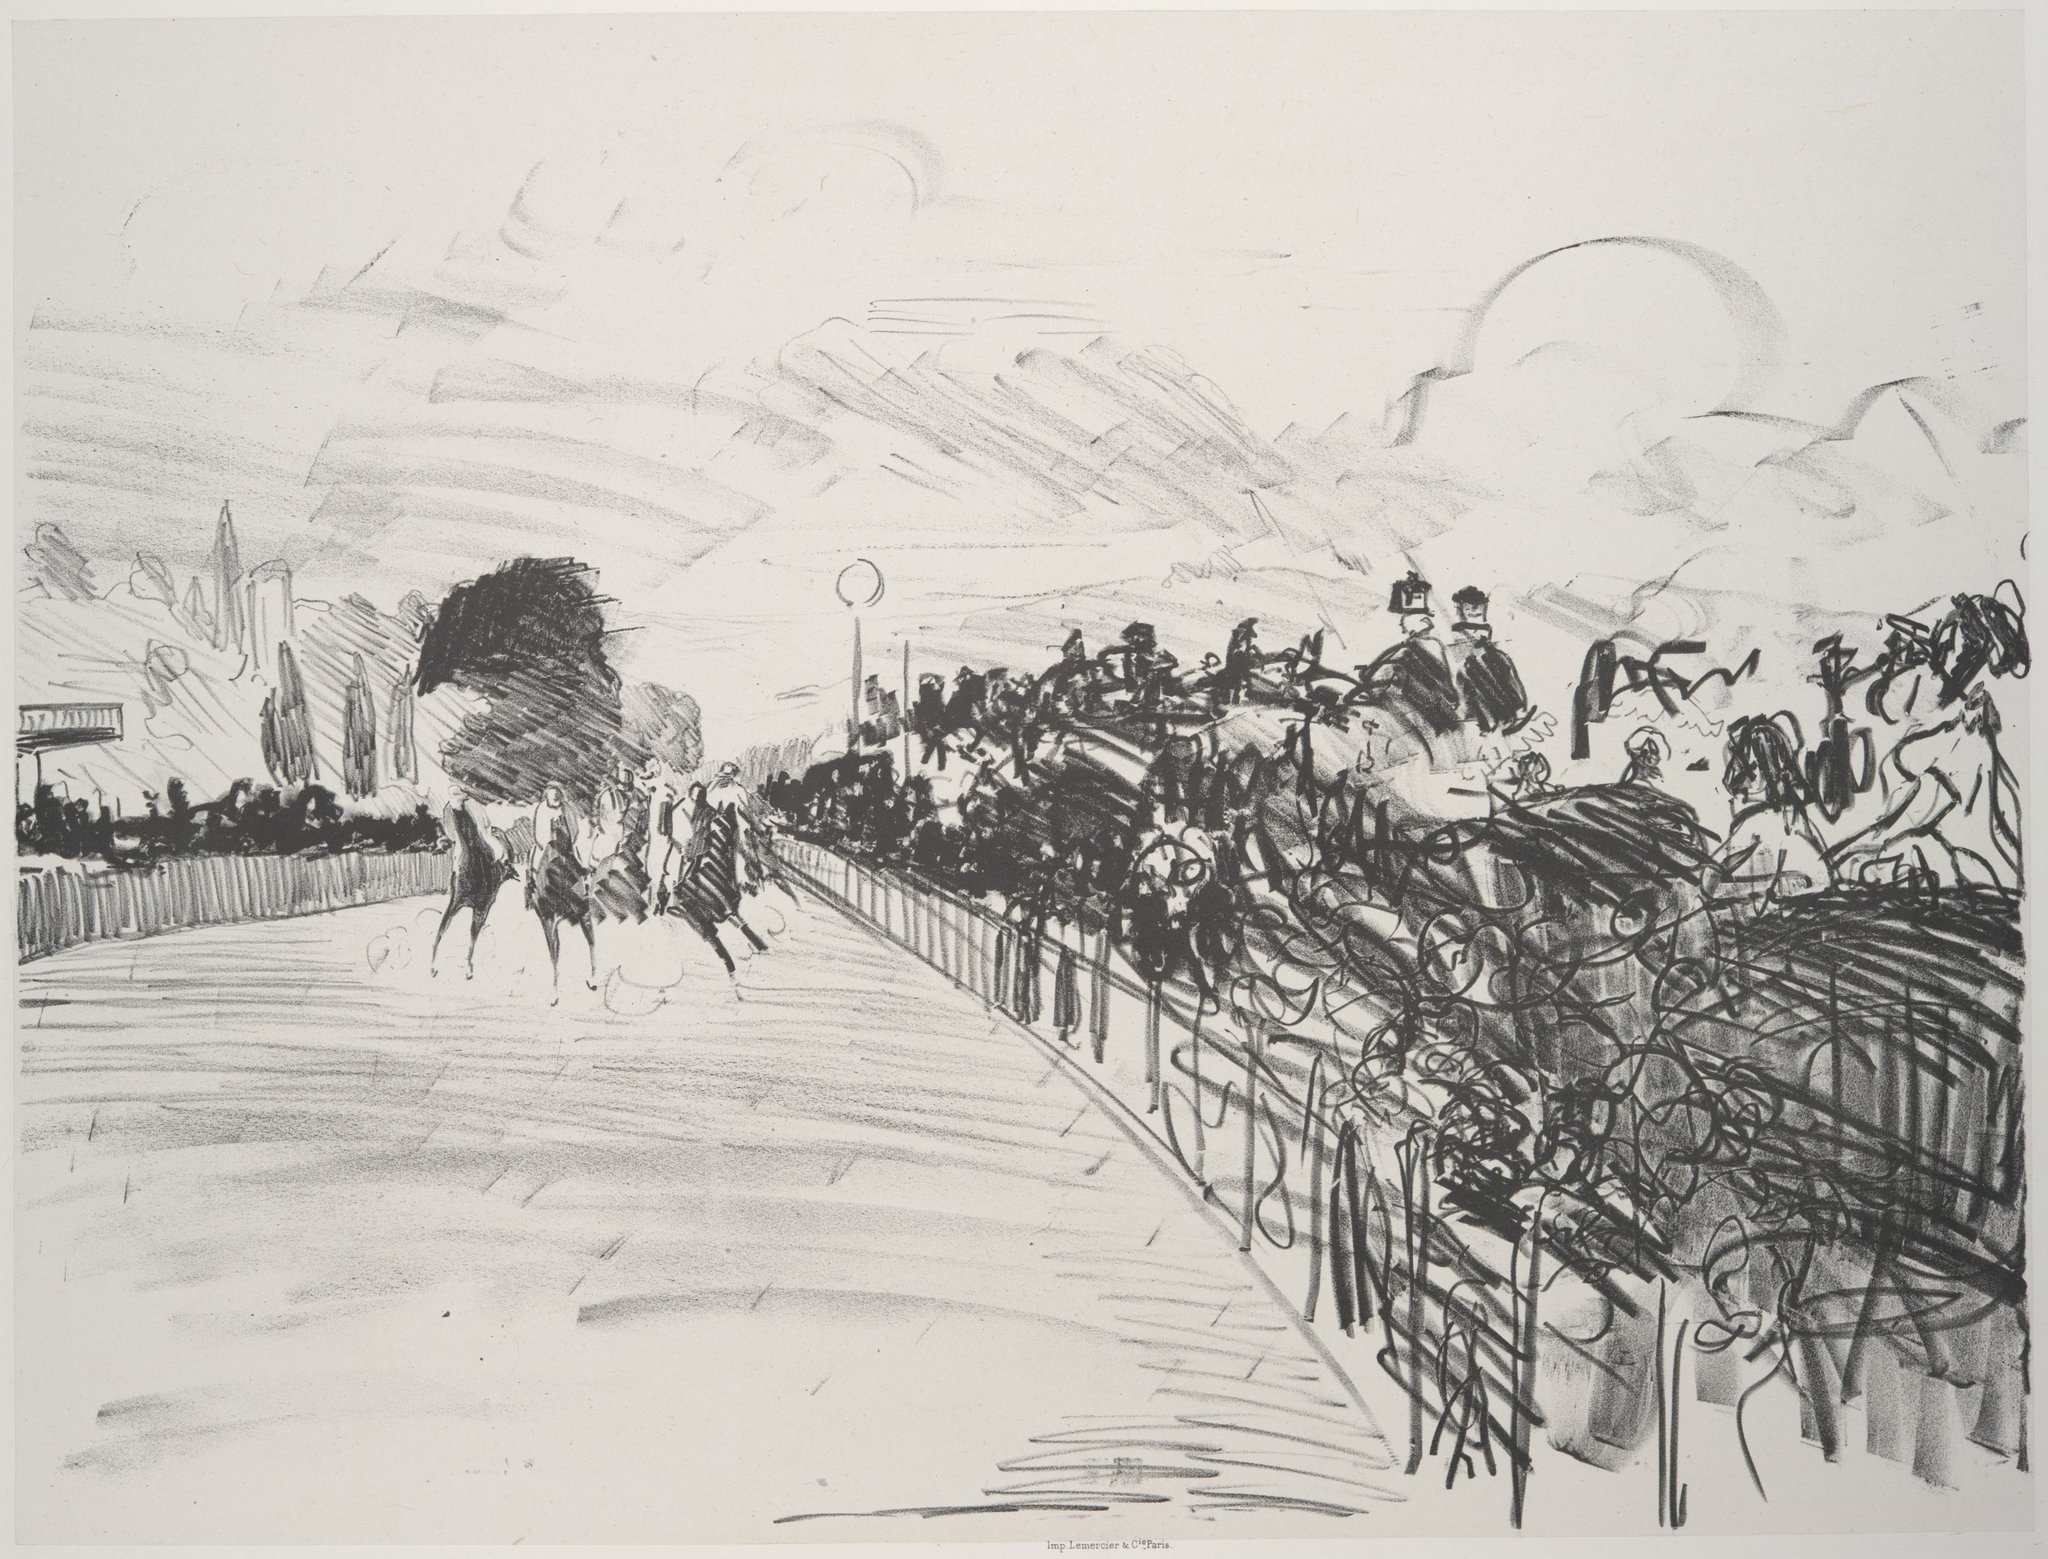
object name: print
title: The Races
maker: édouard manet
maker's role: artist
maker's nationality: french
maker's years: 1832-1883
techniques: printmaking, lithograph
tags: sports,horses